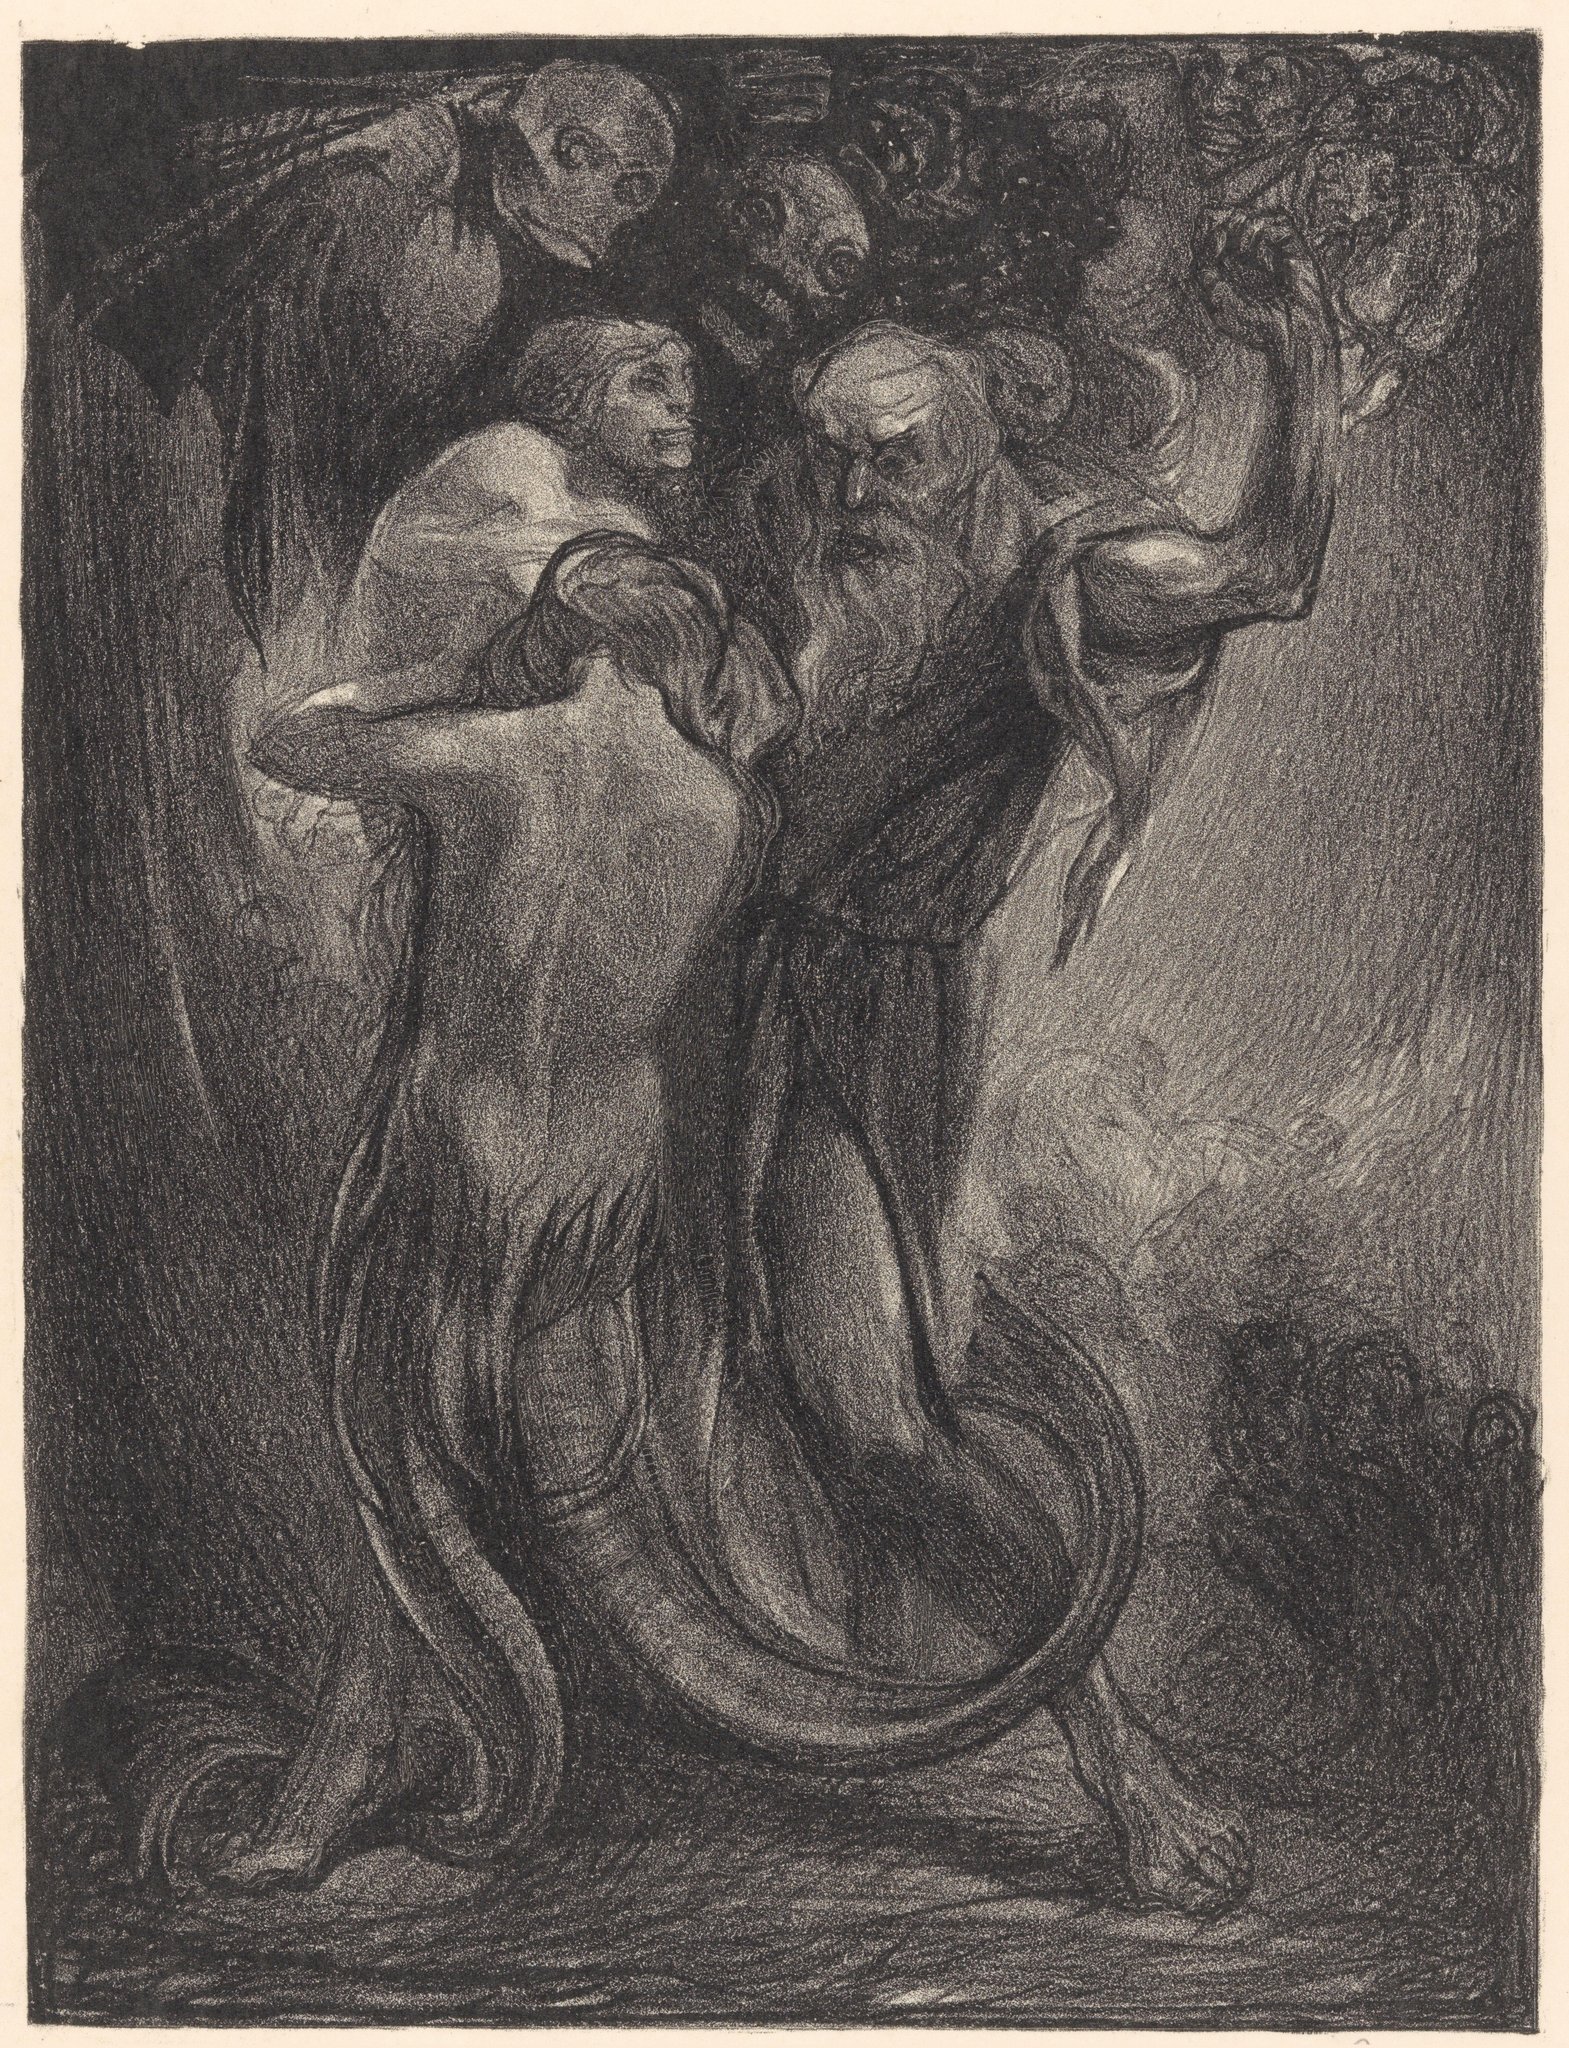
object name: print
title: De verzoeking van de Heilige Antonius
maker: johannes josephus aarts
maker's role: draughtsman, print maker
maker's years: 1871-1934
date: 1927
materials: paper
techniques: lithograph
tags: devil or demons attacking mortals, mis-shapen animals; monsters, st. antony abbot tormented by devils, attacking him on the ground or carrying him aloft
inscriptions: collector's mark: Lugt 2228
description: Een bebaarde man in gevecht met een groep demonen, waarvan het merendeel in de lucht zweeft.